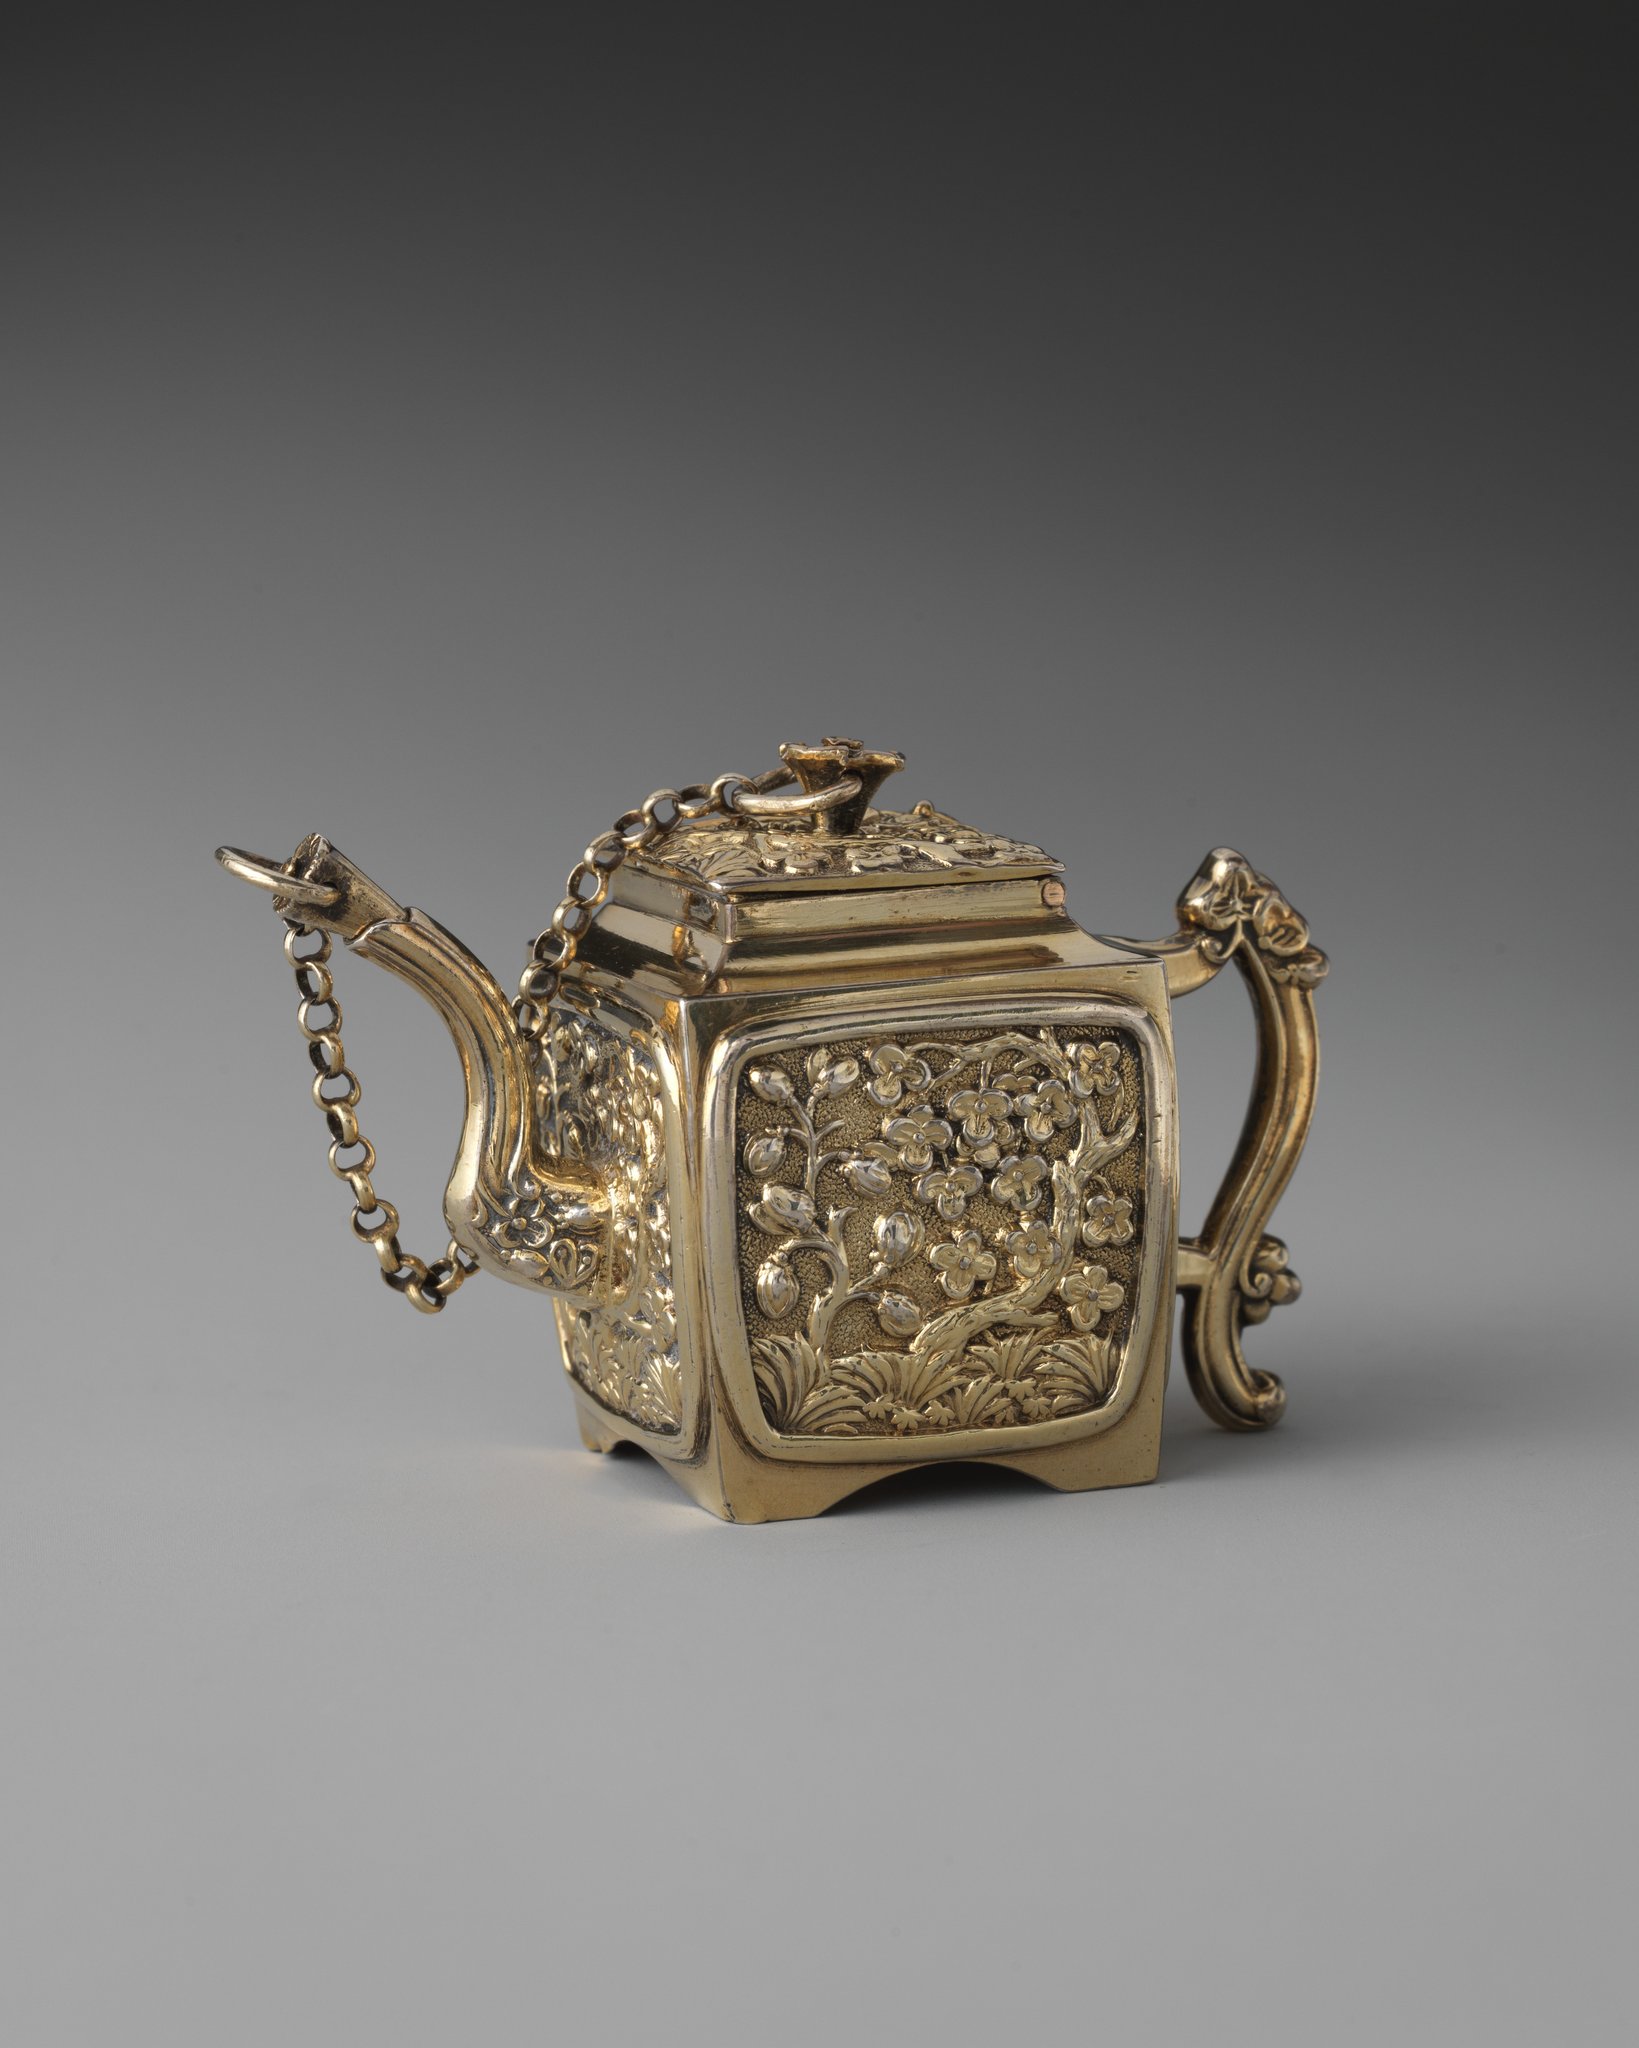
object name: teapot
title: Miniature teapot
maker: joseph willmore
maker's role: maker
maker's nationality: british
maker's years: 1773-1855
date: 1829-1830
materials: silver gilt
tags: flowers